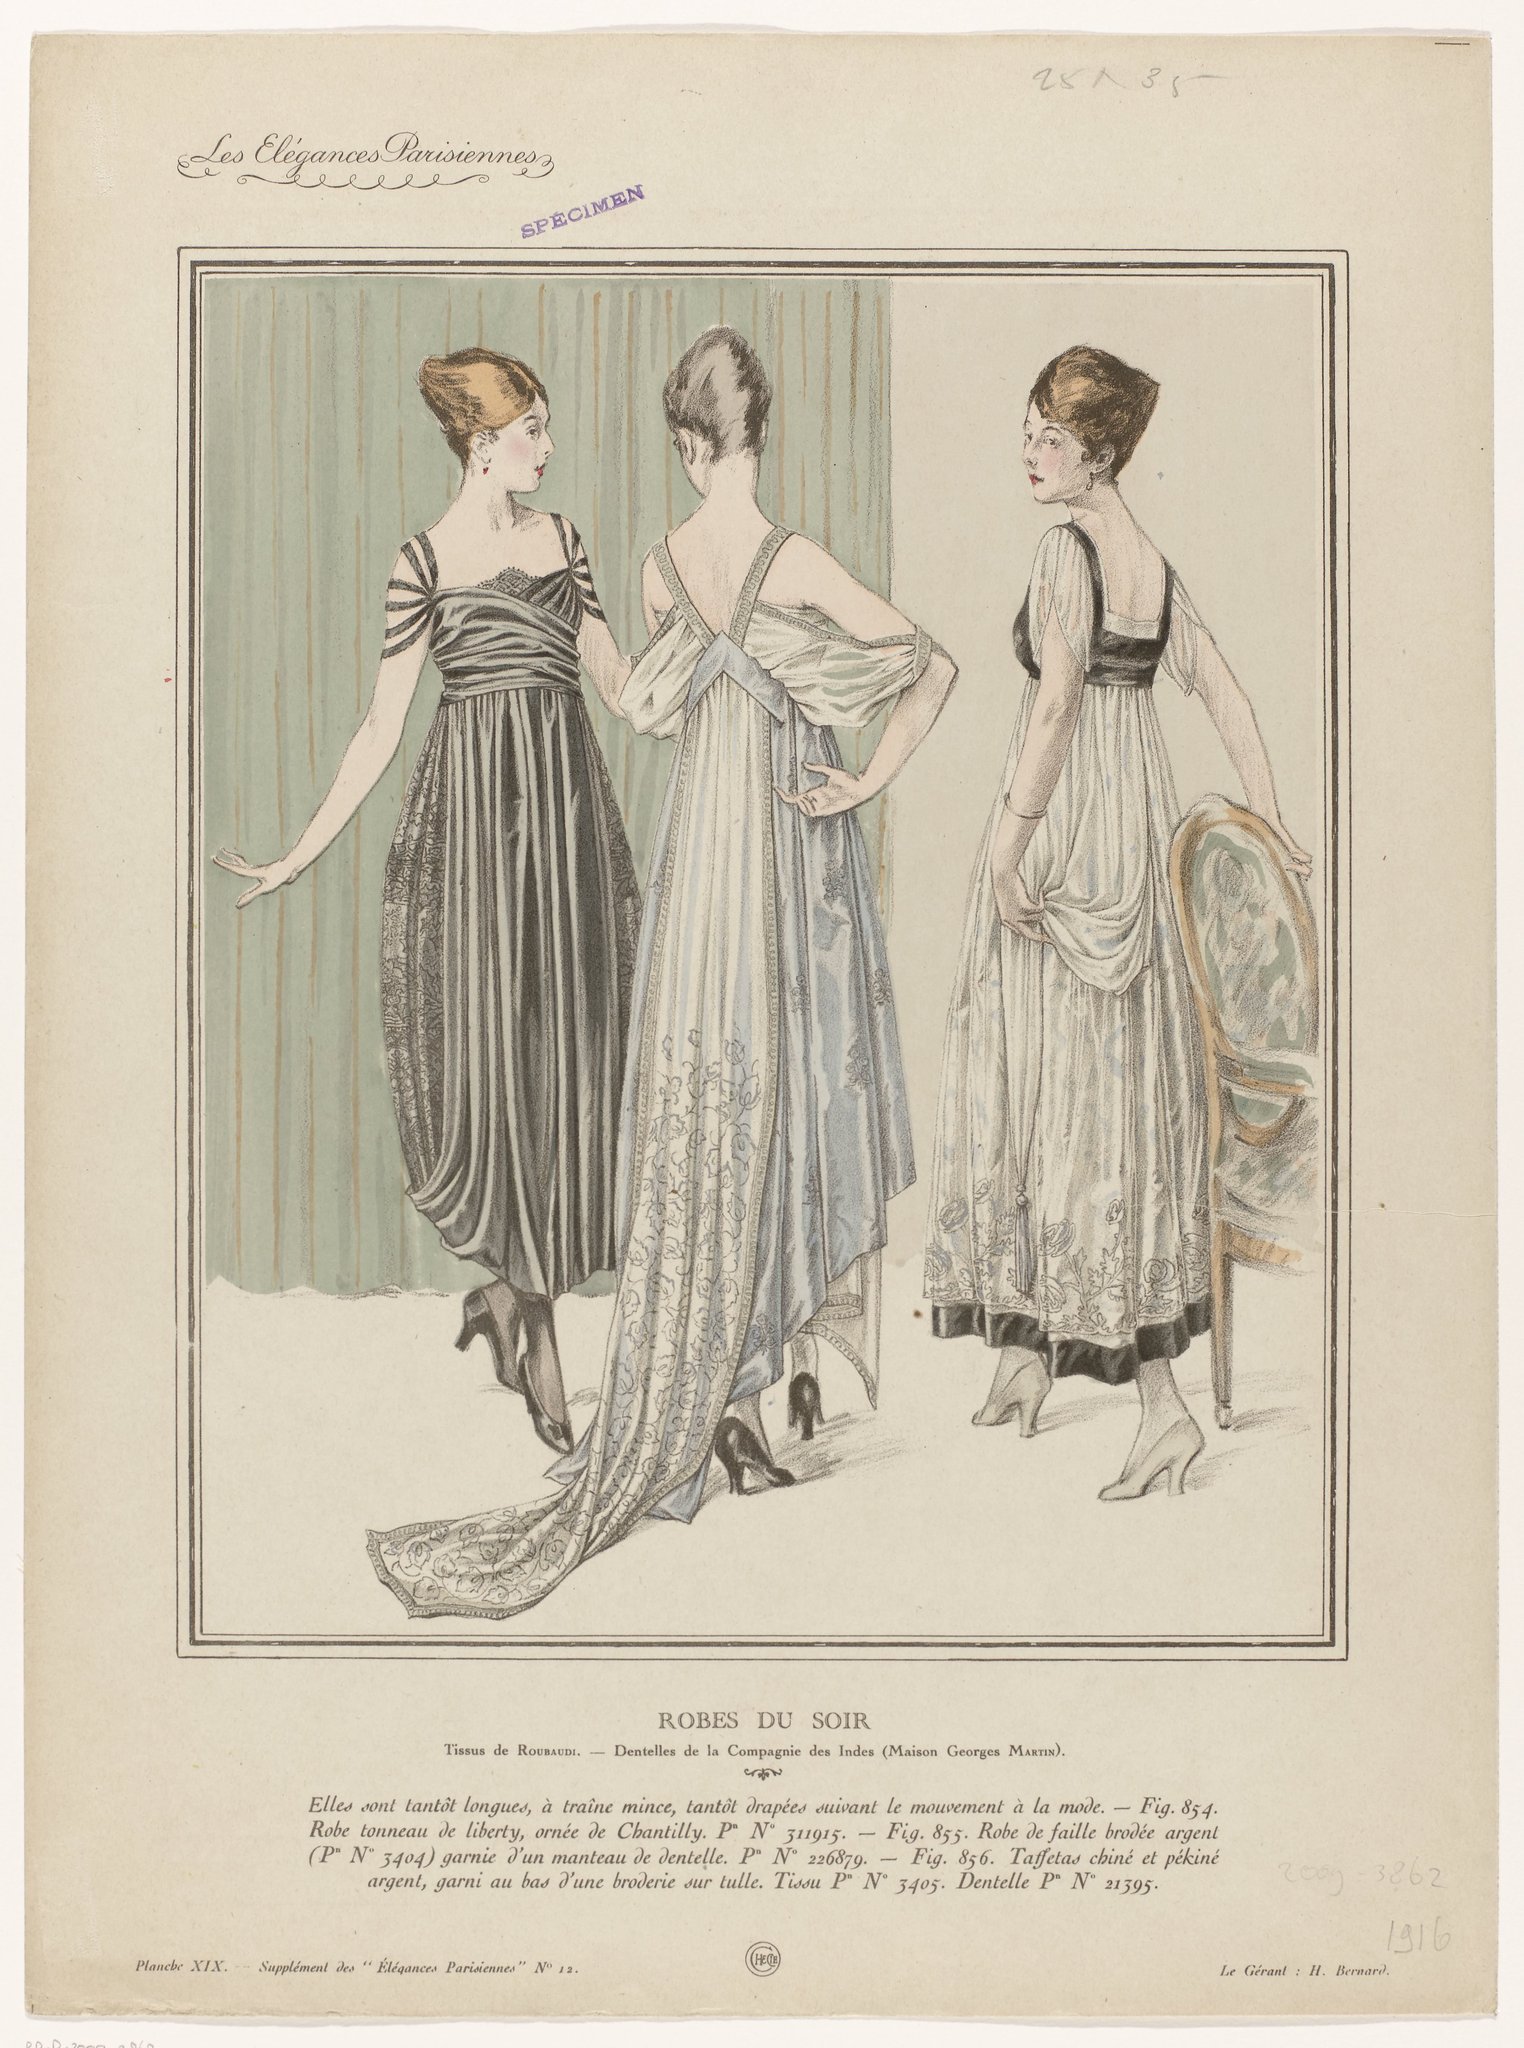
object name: fashion print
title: Les Élégances Parisiennes, ca. 1916, Supplément No 12, Pl. XIX en XX, fig. 854 t/m 863 : ROBES DU SOIR (...)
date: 1916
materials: paper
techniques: brush, hand coloring, lithograph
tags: dress, gown: evening dress (+ women's clothes), embroidery (ornamentation) (+ women's clothes), lace (+ women's clothes), head-gear: hat (+ girls' clothes), embroidery (ornamentation) (+ girls' clothes), fashion plates, dog, dress, gown (+ girls' clothes)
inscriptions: inscription: ‘Planche XX. - Supplément des "Élégances Parisiennes" No 12. / Le Gerant: H. Bernard.’, caption: ‘Fig. 857. Robe de toile pékinée (pn No 6019), ornée de broderies de laine, petit col empesé._ Fig. 858. Robe de toile, garnie d'un casaquin à damiers. Pn No 6045. _ Fig. 859. Mousseline quadrillée, semée de cerises; casaquin pékiné. Pns Nos 7018 et 7216._Fig. 860. Robe de toile semée de fleurs et brodée de coton rose. Pn No 7008._Fig. 861. toile brodée de coton Nattier. Pn No 9429. _ Fig. 862. Toile blanche semée de bouquets cachemire (pn No 7031), casaquin de shantung. _Fig. 863. Mousseline à fleurettes, casaquin de shantung brodé. Pn No 7203..’, title: ‘Les Elégances Parisiennes’, caption: ‘ROBES DU SOIR / Tissus de ROUBAUDI. - Dentelles de la Compagnie des Indes ( Maison Georges MARTIN).’, stamp: ‘SPÉCIMEN’, inscription: ‘Planche XIX. - Supplément des "Élégances Parisiennes" No 12. / Le Gerant: H. Bernard.’, caption: ‘Elles sont tantôt longues, à traîne mince, tantôt drapées suivant le mouvement à la mode. - Fig. 854. Robe tonneau de liberty, ornée de Chantilly. Pn No 311915. - Fig. 855. robe de faille brodée argent (pn No 3404) garnie dúnmanteau de dentelle. Pn No 226879. - Fig. 856. Taffetas chiné et pékiné argent, garni au bas d'une broderie sur tulle. tissu Pn No 3405. Dentelle Pn No 21395.’, caption: ‘LA MODE ENFANTE / Tissus de SIMONNOT-GODARD.’, title: ‘Les Elégances Parisiennes’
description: Recto: Drie vrouwen gekleed in avondjaponnen, genummerd fig. 854, 855 en 856. Volgens het onderschrift: Stoffen van Roubaudi. Kant van Compagnie des Indes (Maison Georges Martin). Fig. 854: japon van liberty, versierd met 'Chantilly'. Fig. 855: japon van faille geborduurd met zilverkleurig draad en gegarneerd met een 'manteau' van kant. Fig. 856: japon van 'taffetas chiné' (tafzijde) en zilverkleurig 'pékiné', aan de onderkant versierd met een 'broderie sur tulle'. Verso: Zeven meisjes van verschillende leeftijden in modieuze kinderkleding, genummerd fig.857 t/m 863. Volgens het onderschrift: Stoffen van Simonnot-Godard. Prent uit het modetijdschrift Les Élégances Parisiennes (1916-1924).